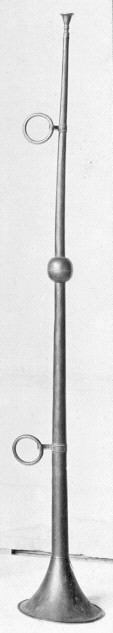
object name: herald's trumpet in c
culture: german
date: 1801-1900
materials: brass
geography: germany